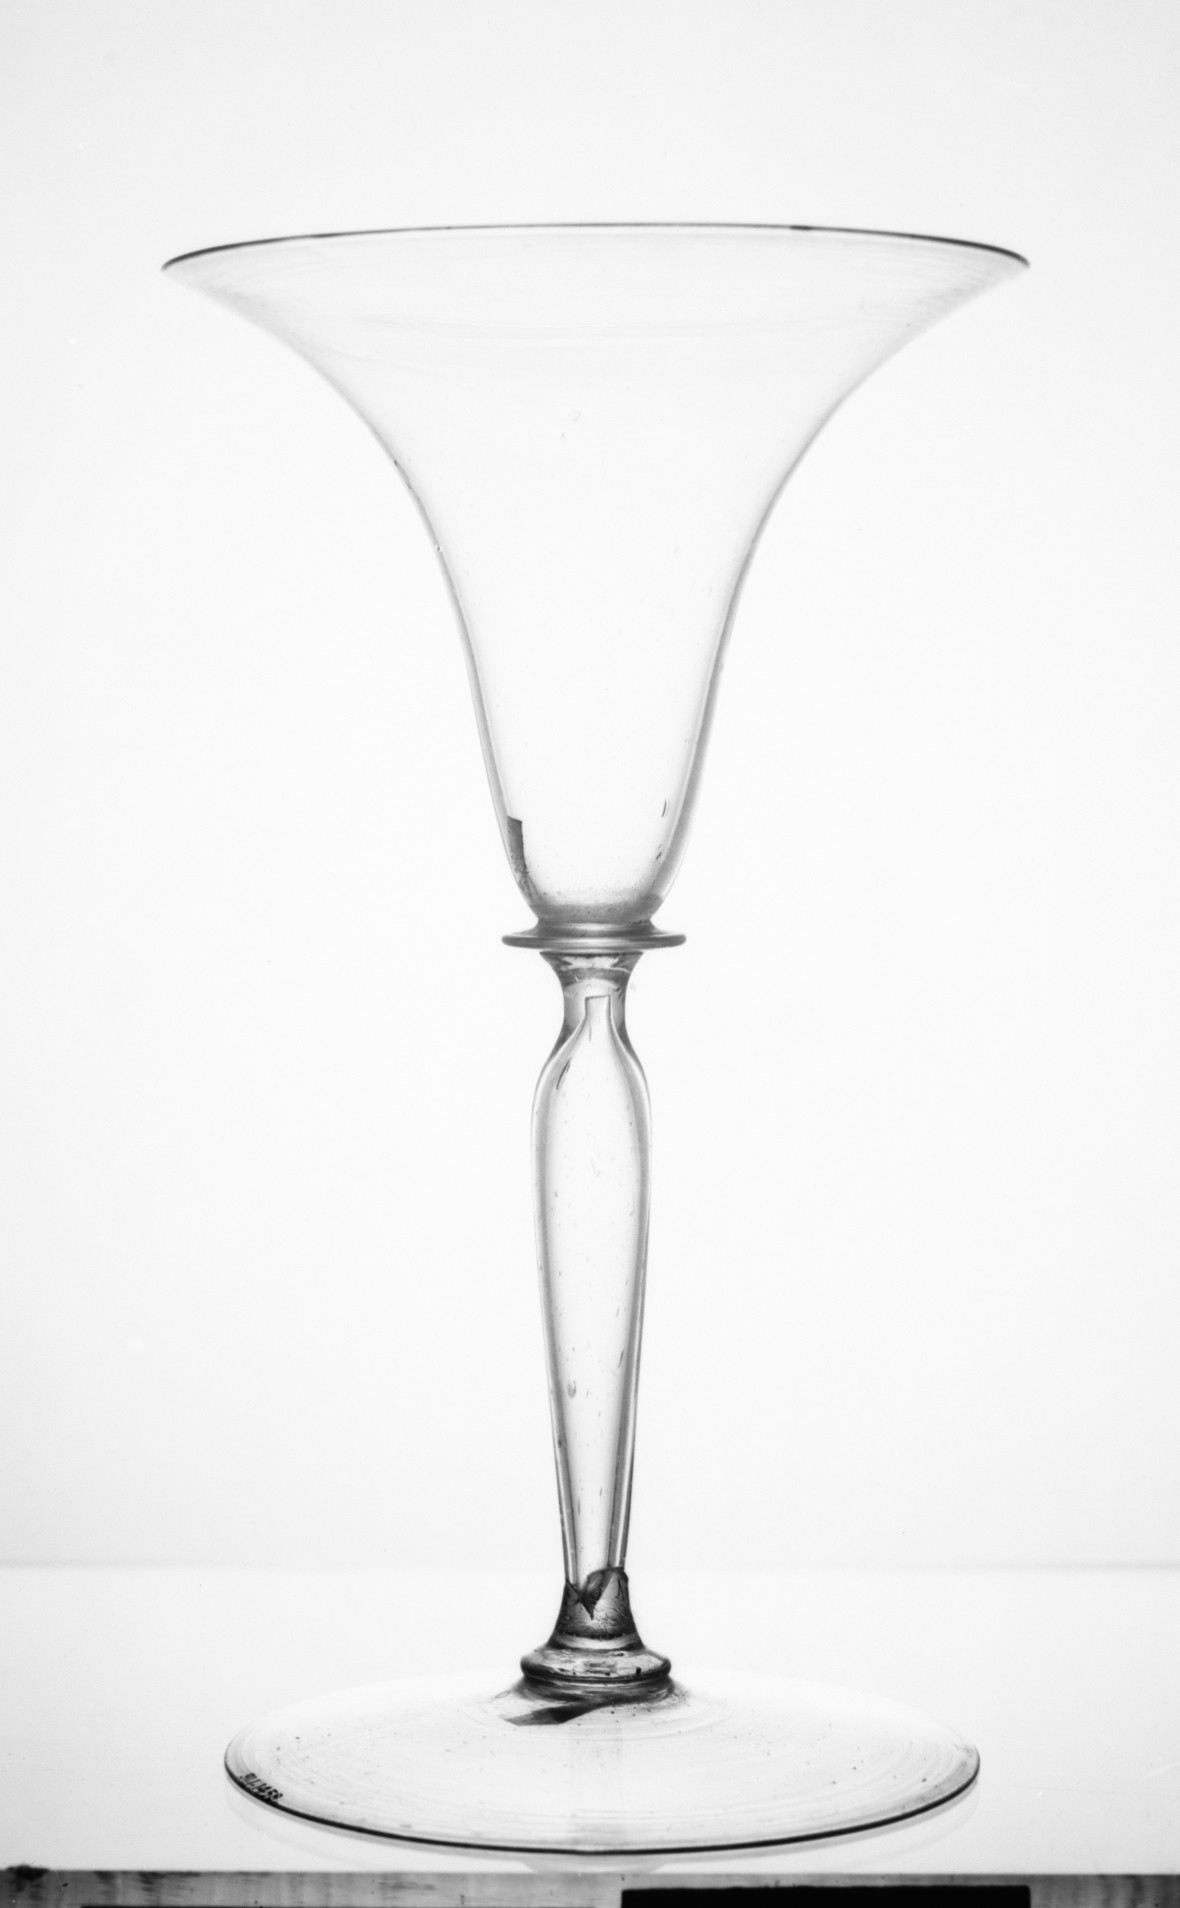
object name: wineglass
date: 1501-1600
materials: glass